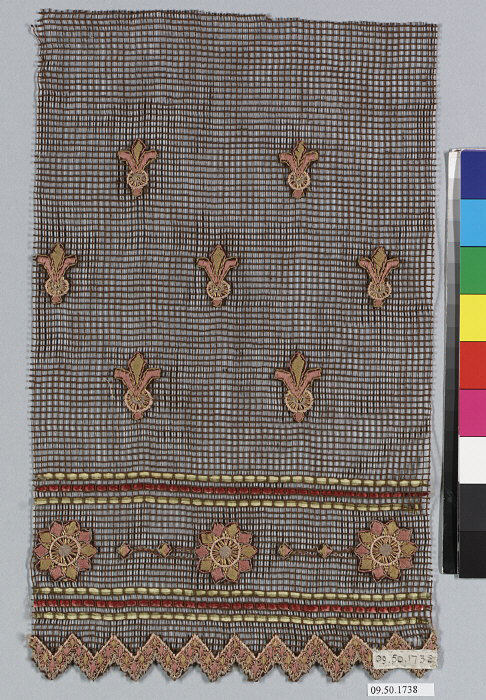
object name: fragment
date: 1801-1900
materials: lace